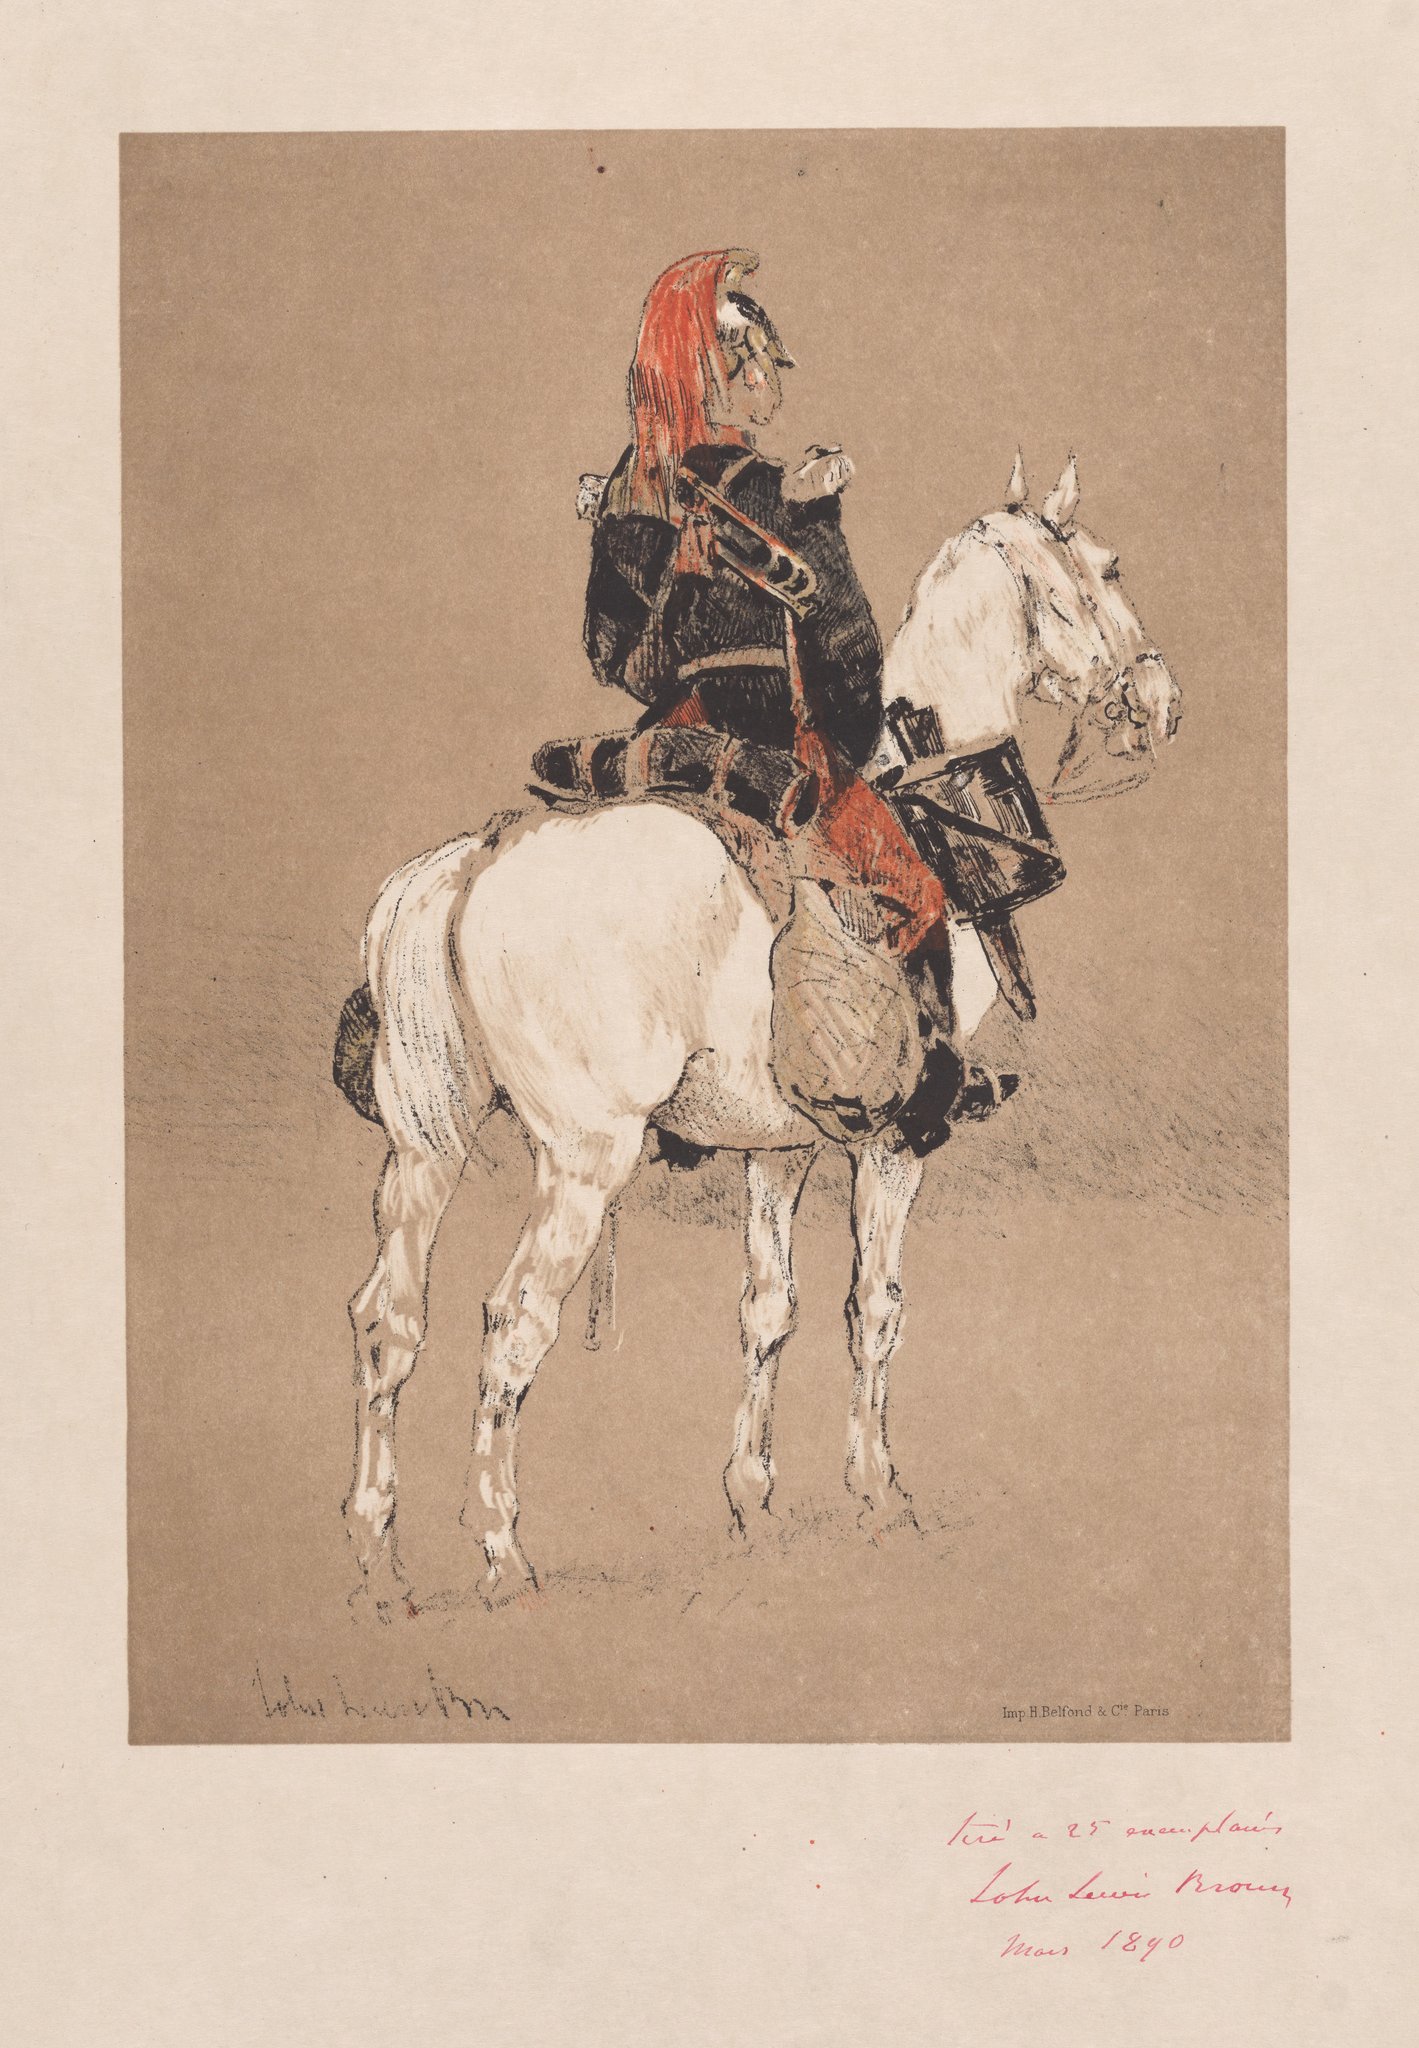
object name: print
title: Trompette de dragons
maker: john-lewis brown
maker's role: artist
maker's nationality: french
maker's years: 1829-1890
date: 1890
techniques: lithograph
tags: men,horses